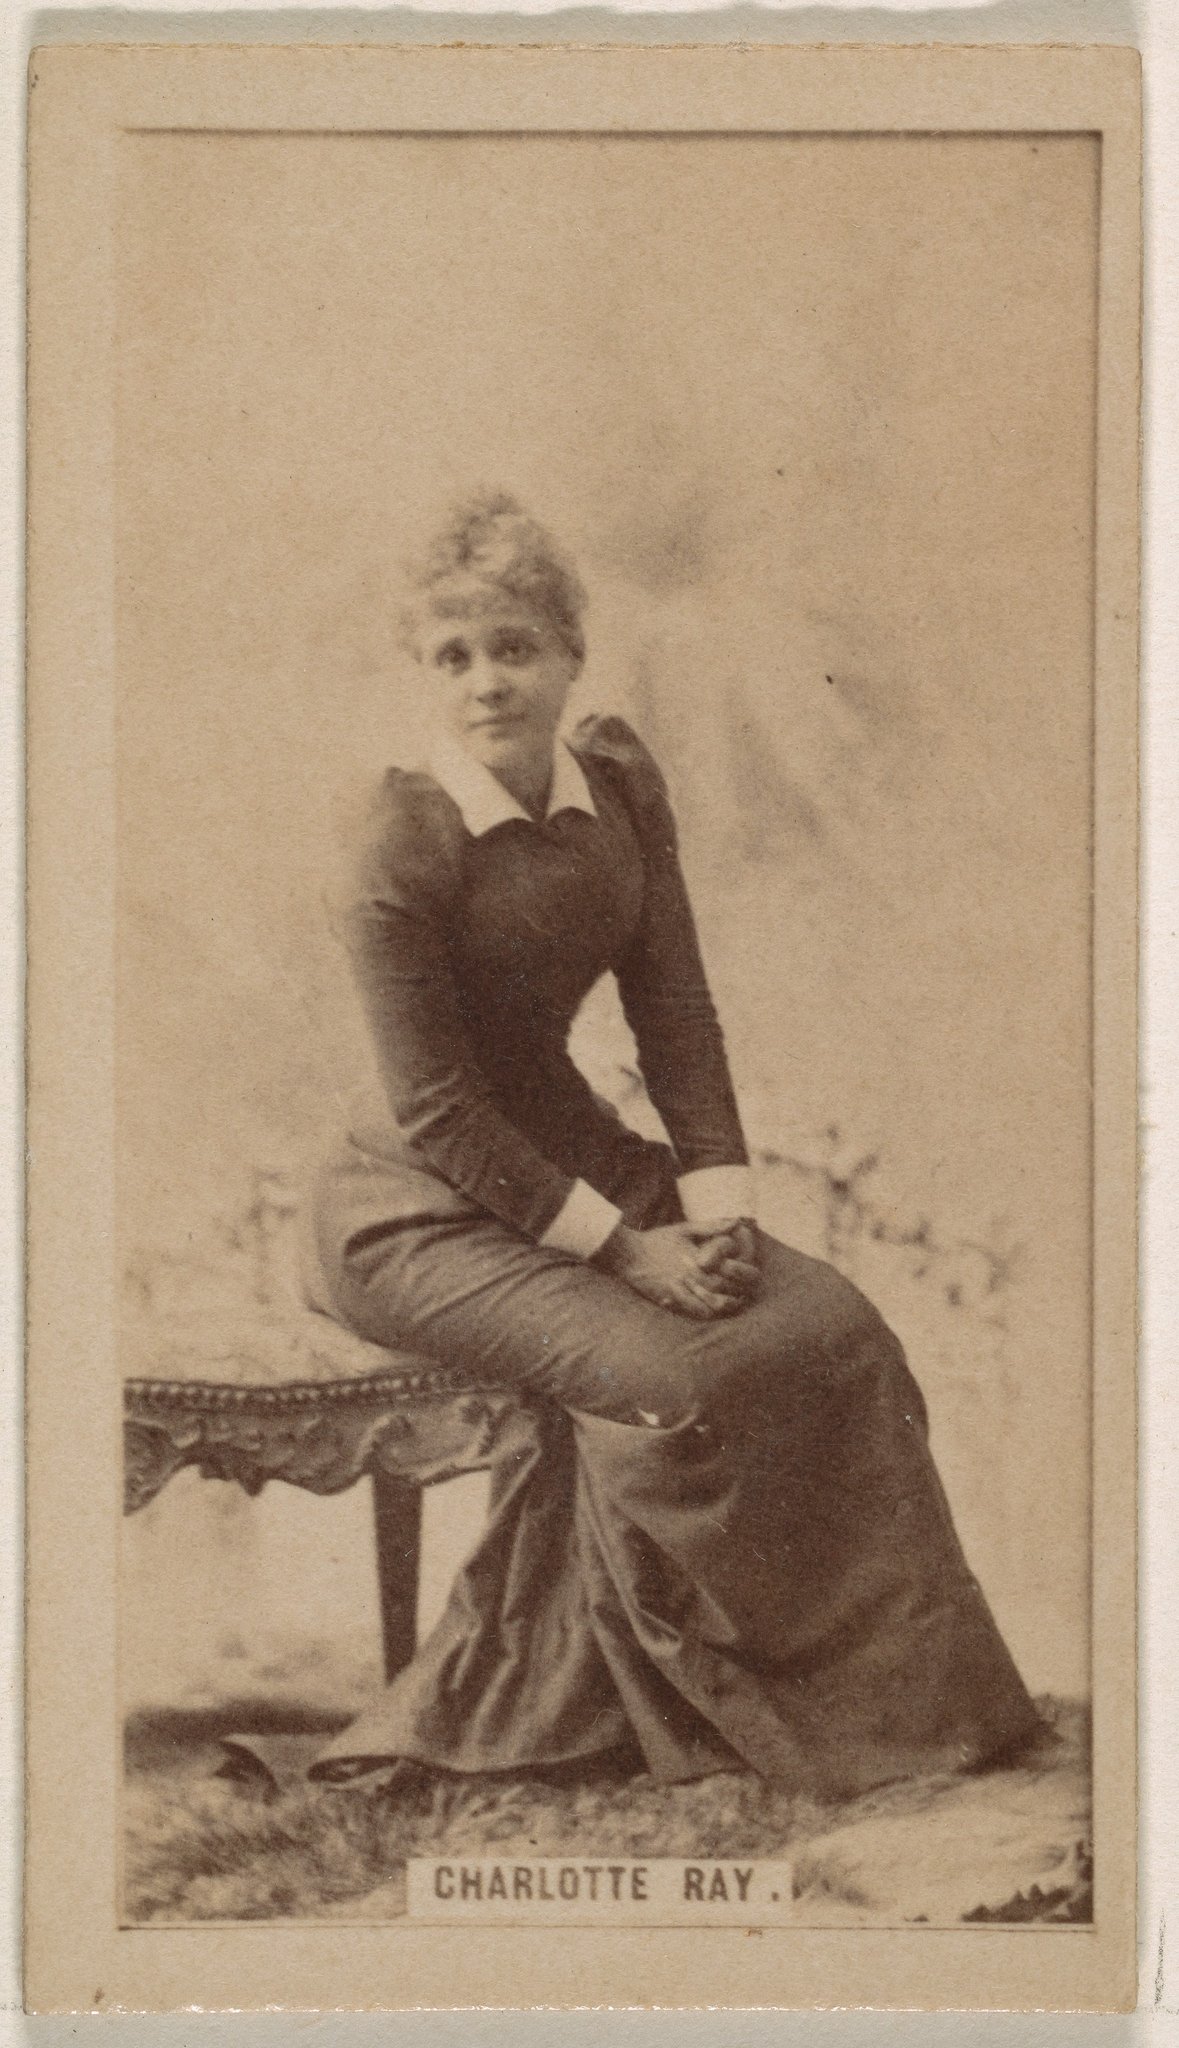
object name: photograph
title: Charlotte Ray, from the Actresses series (N245) issued by Kinney Brothers to promote Sweet Caporal Cigarettes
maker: kinney brothers tobacco company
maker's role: publisher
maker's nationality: american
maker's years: 1869-2011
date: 1890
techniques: albumen silver print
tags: portraits,women,actresses